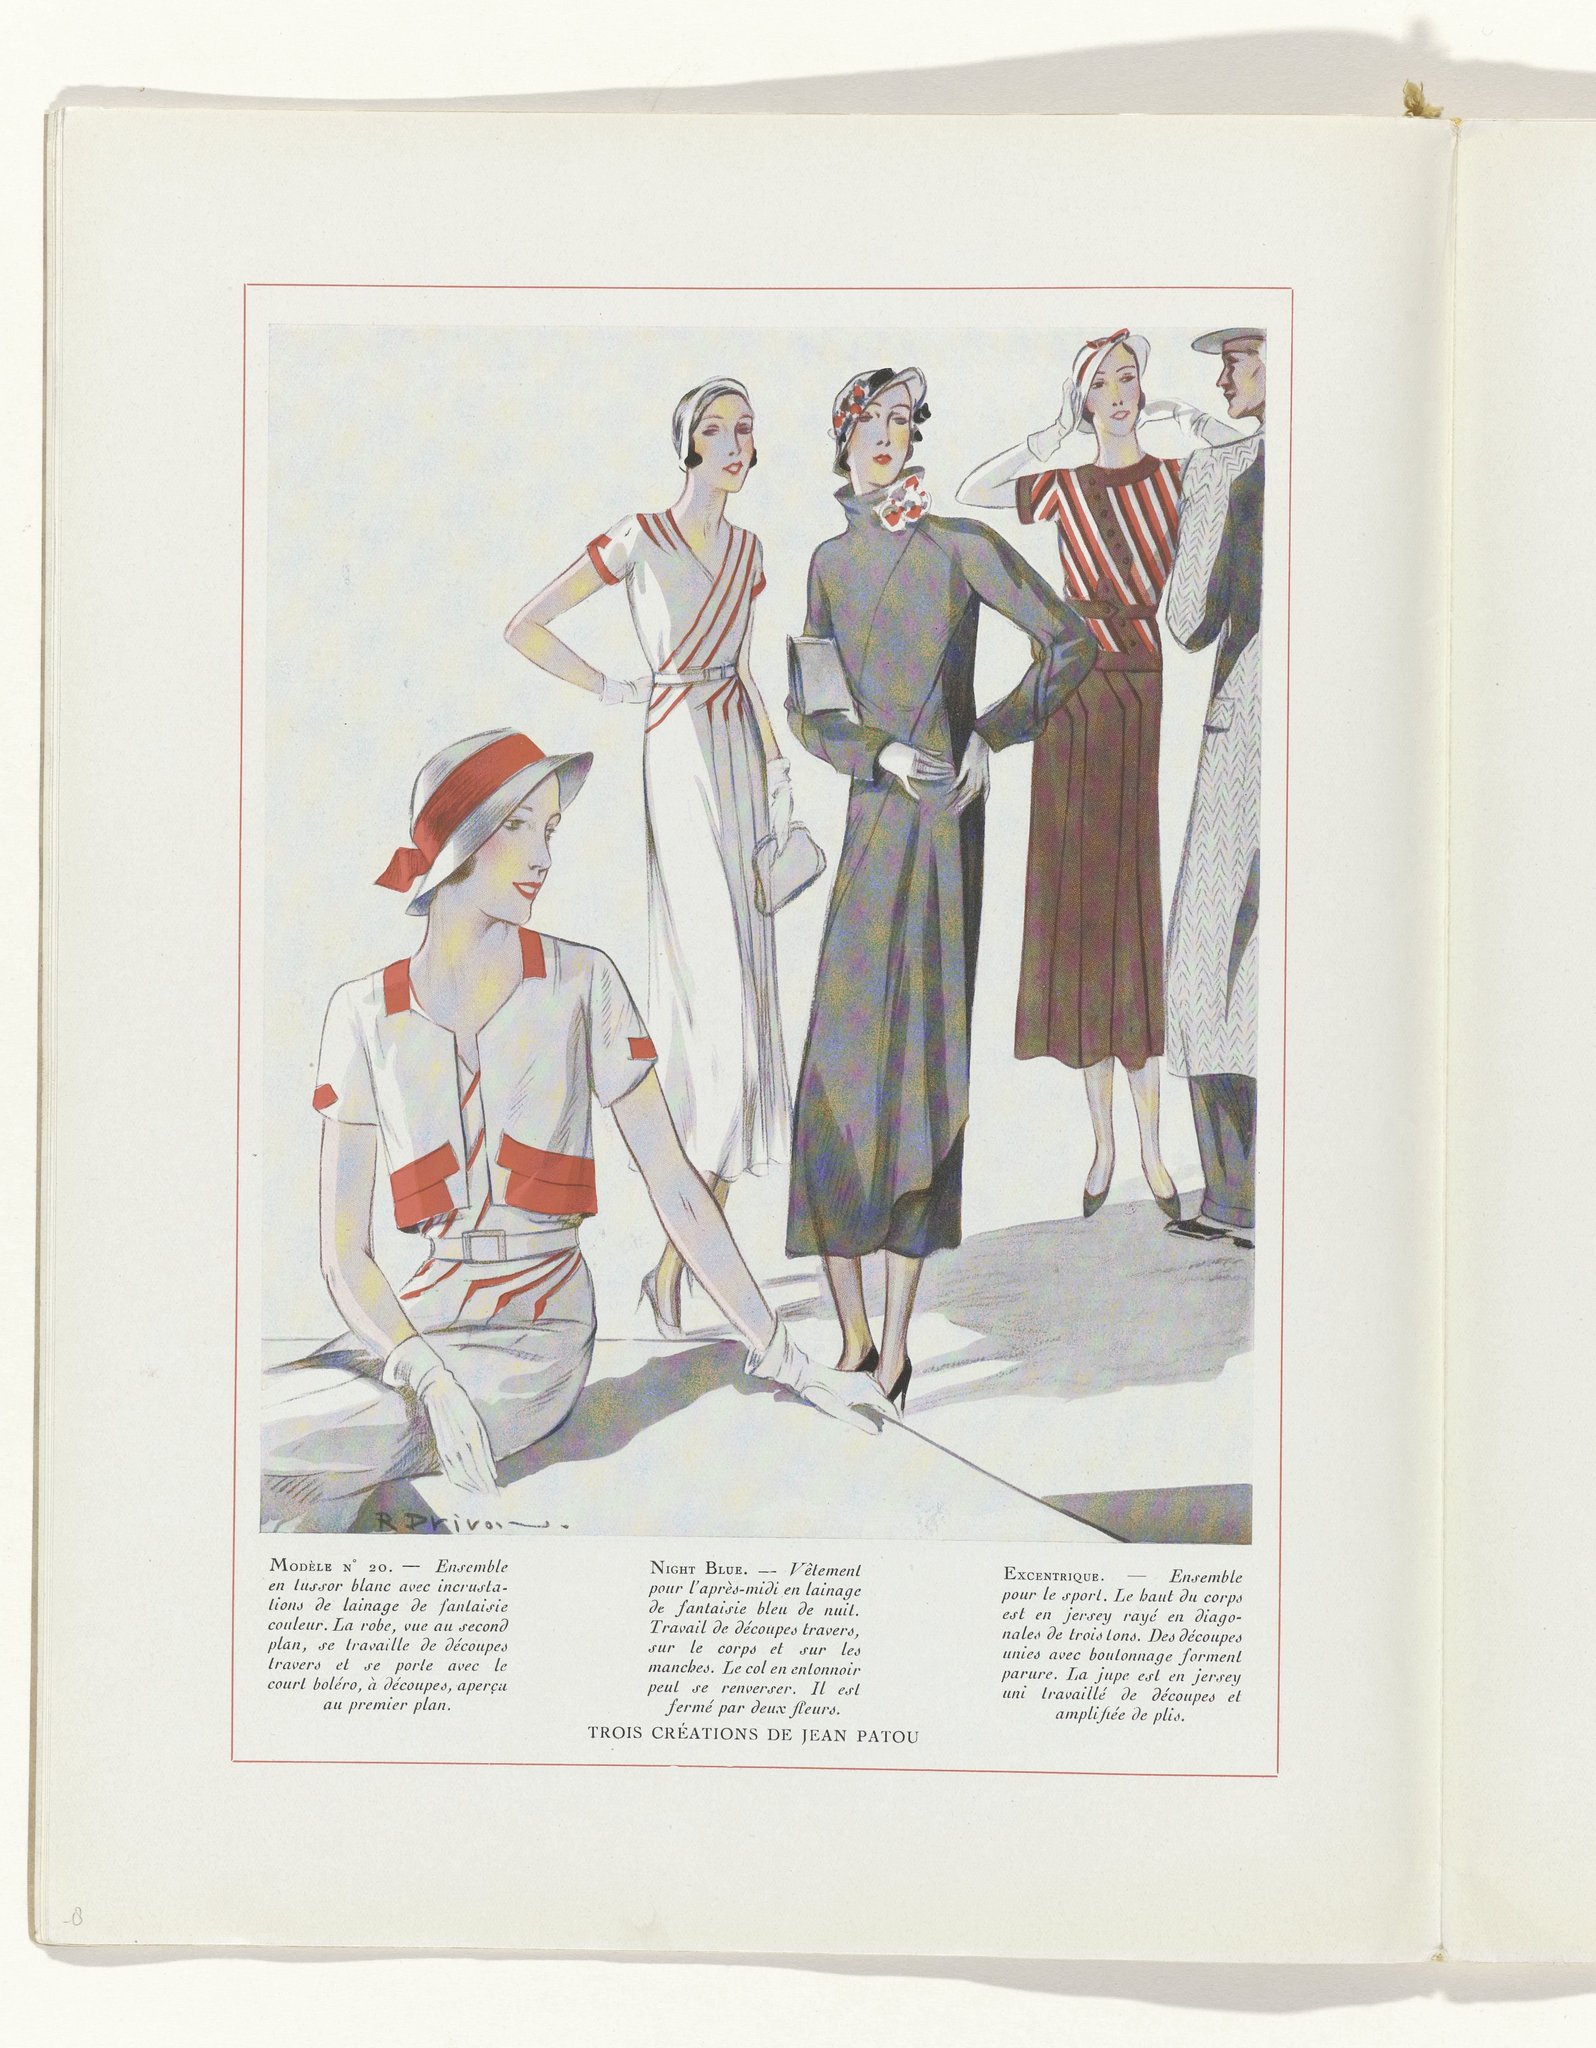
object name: fashion print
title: Art - Goût - Beauté, Feuillets de l' élégance féminine, Juin 1932, No. 142, 12e Année, p. 8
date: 1932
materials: paper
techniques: printing, photography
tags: clothing for the upper part of the body (+ women's clothes), gloves, mittens (short gloves) (+ women's clothes), clothing for the upper part of the body (bolero) (+ women's clothes), fashion plates, head-gear: hat (+ women's clothes), skirt (+ women's clothes), dress, gown (+ women's clothes)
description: Drie creaties van jean Patou. Pagina uit het modetijdschrift Art-Goût-Beauté (1920-1933).